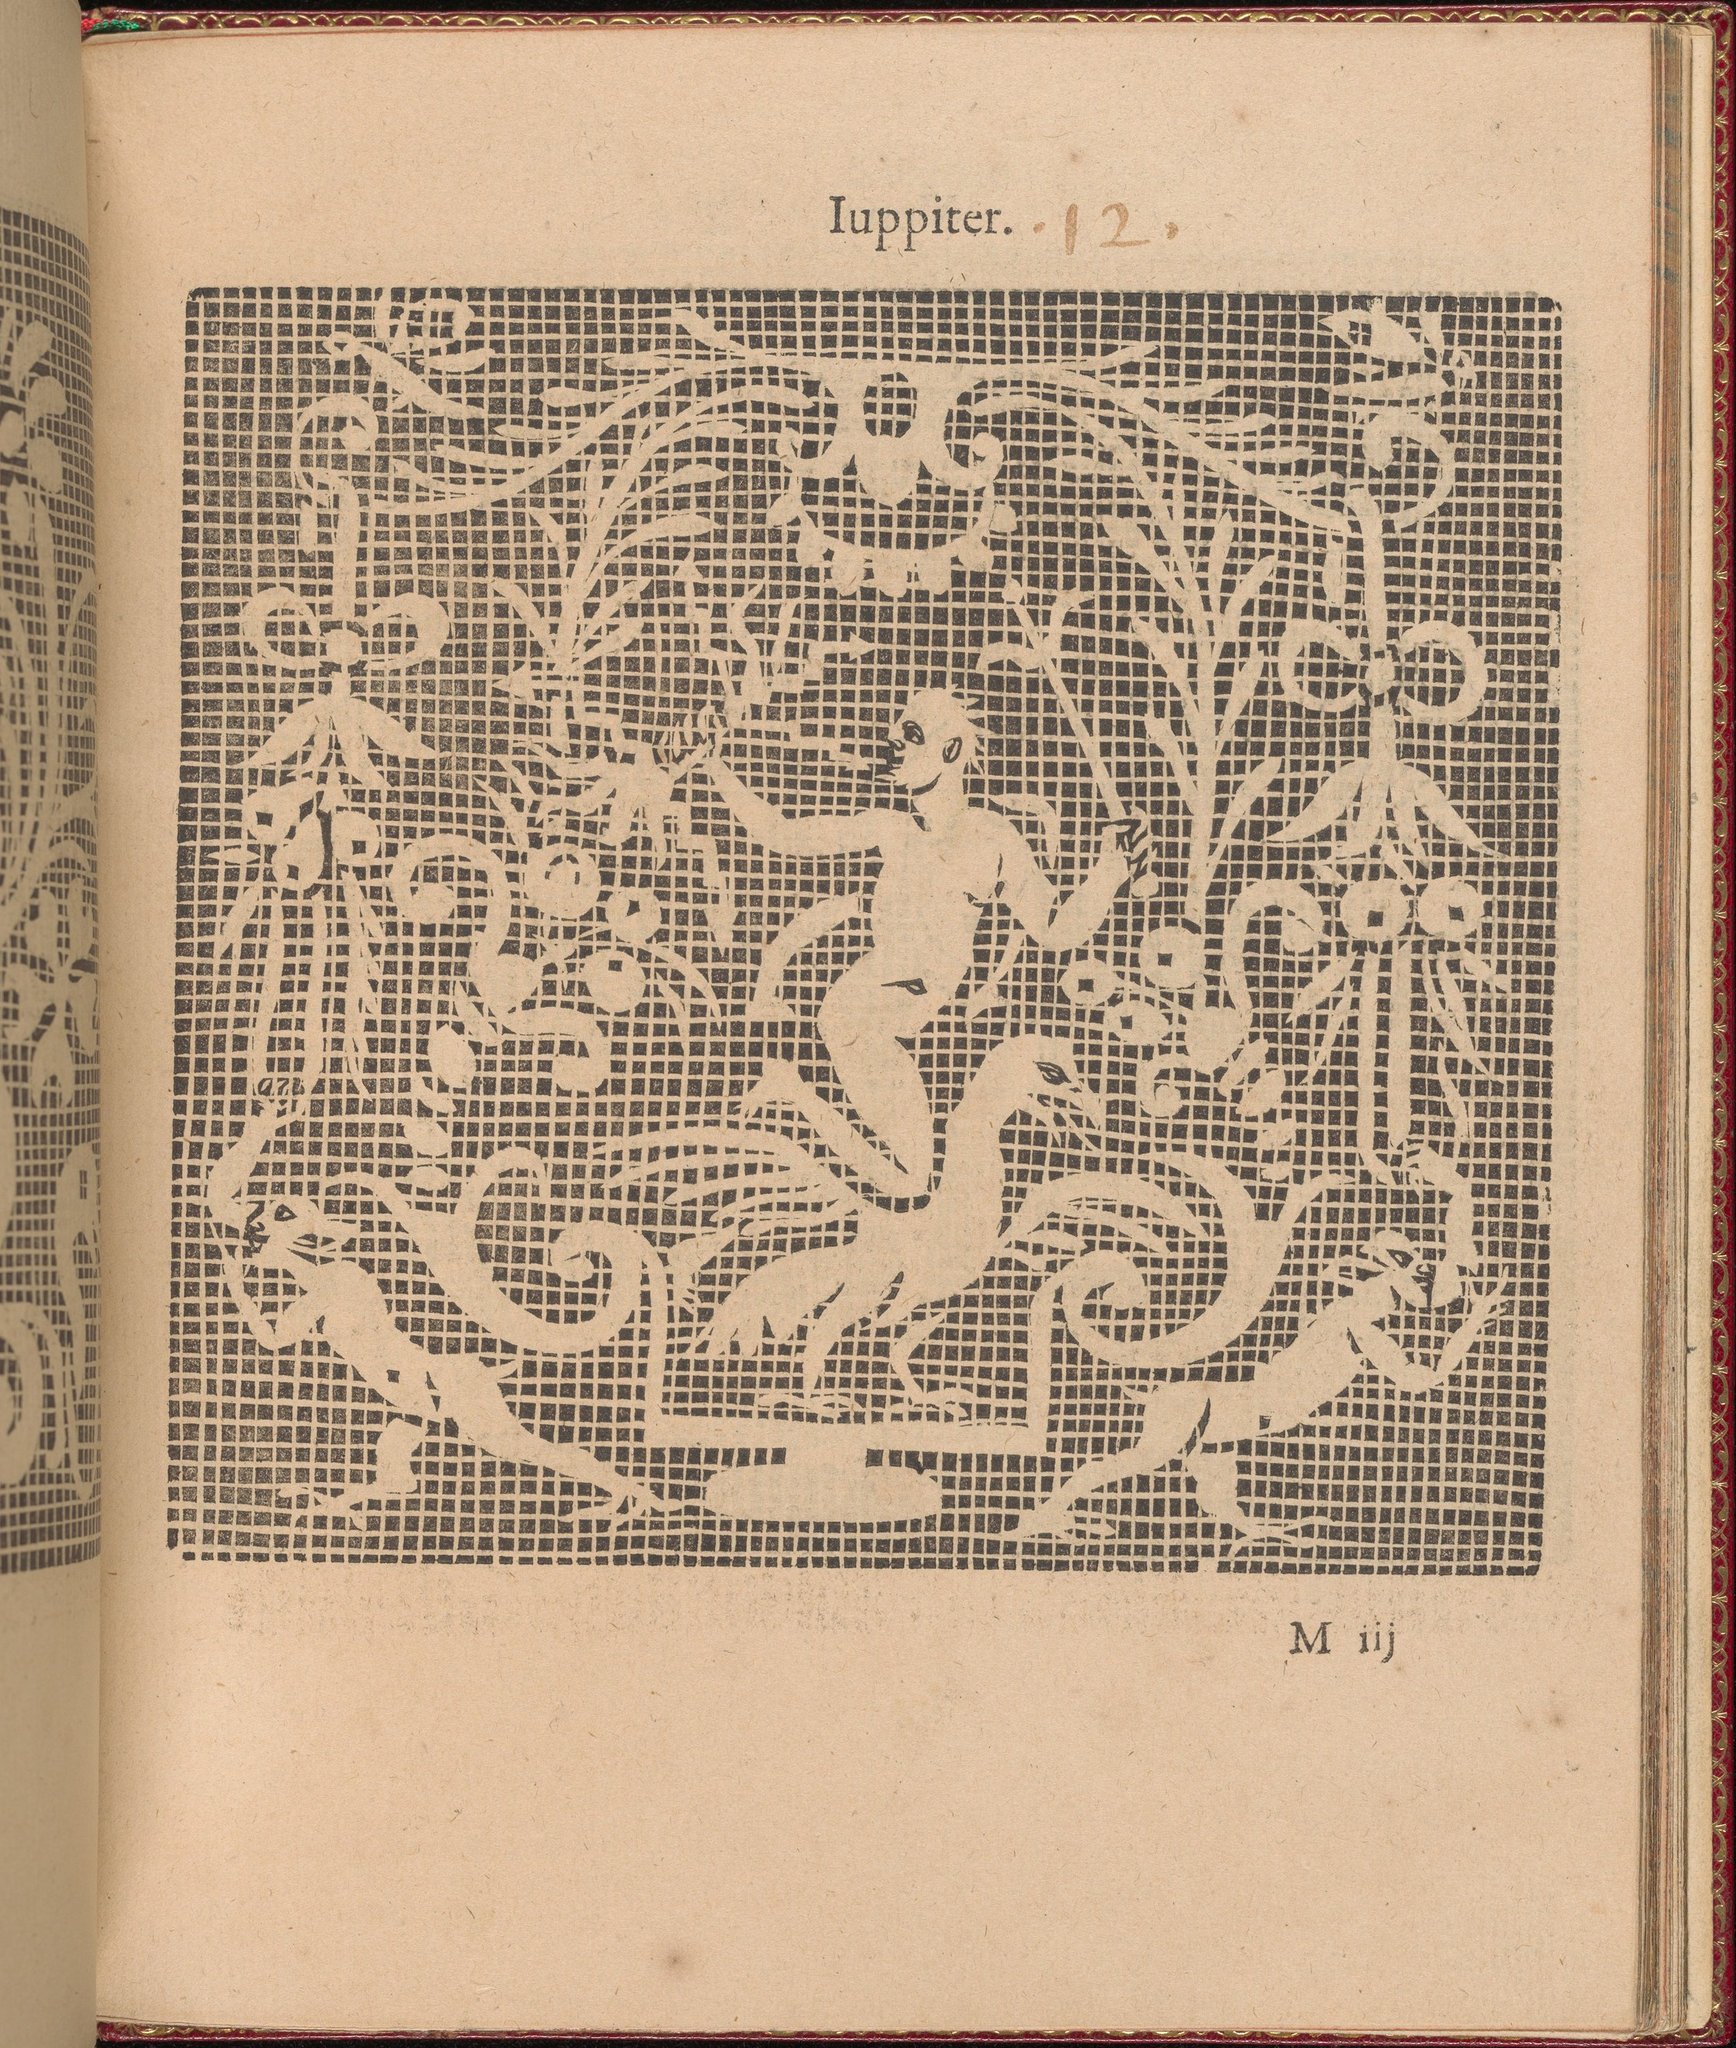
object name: book print ornament architecture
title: Les Singuliers et Nouveaux Portraicts... page 47 (recto)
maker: federico de vinciolo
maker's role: designer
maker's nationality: italian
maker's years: 1582-1599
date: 1588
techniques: woodcut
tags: eagles,jupiter